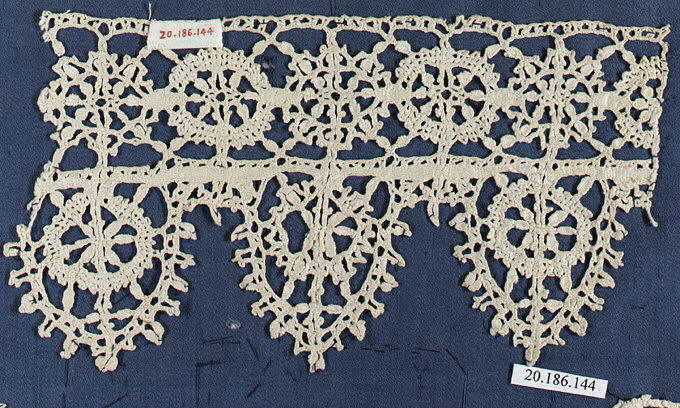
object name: edging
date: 1601-1700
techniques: lace